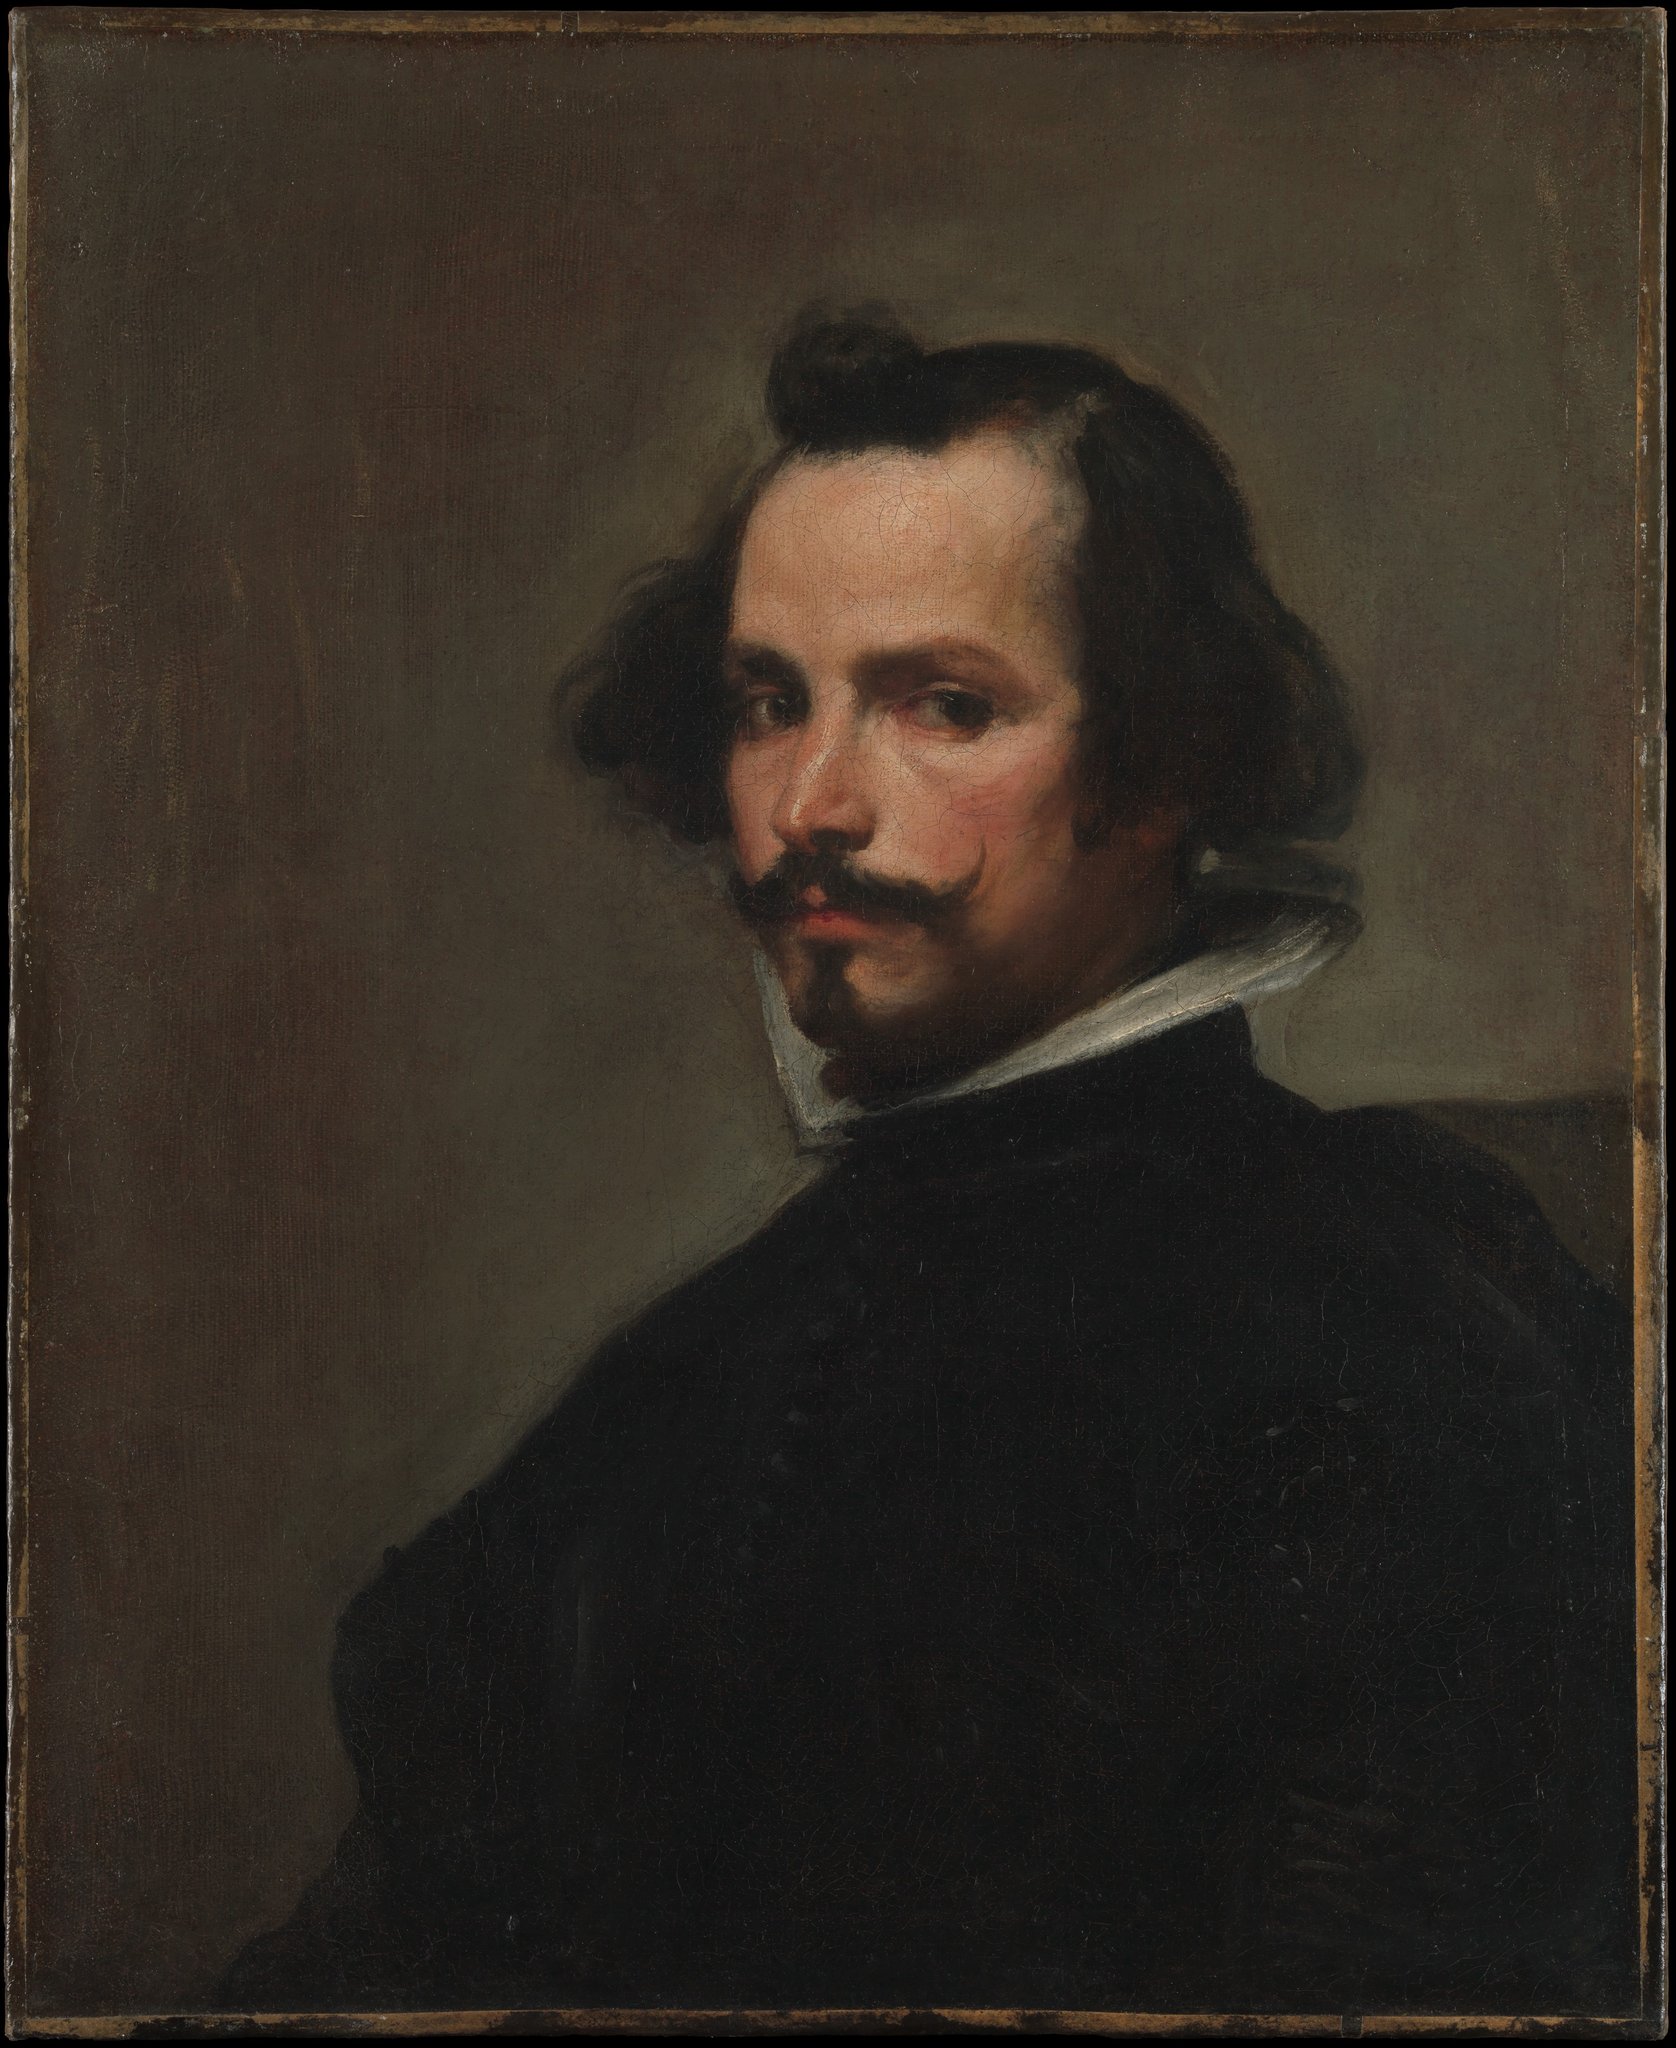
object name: painting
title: Portrait of a Man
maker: velázquez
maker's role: artist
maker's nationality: spanish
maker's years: 1599-1660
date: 1650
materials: canvas, oil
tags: men,portraits